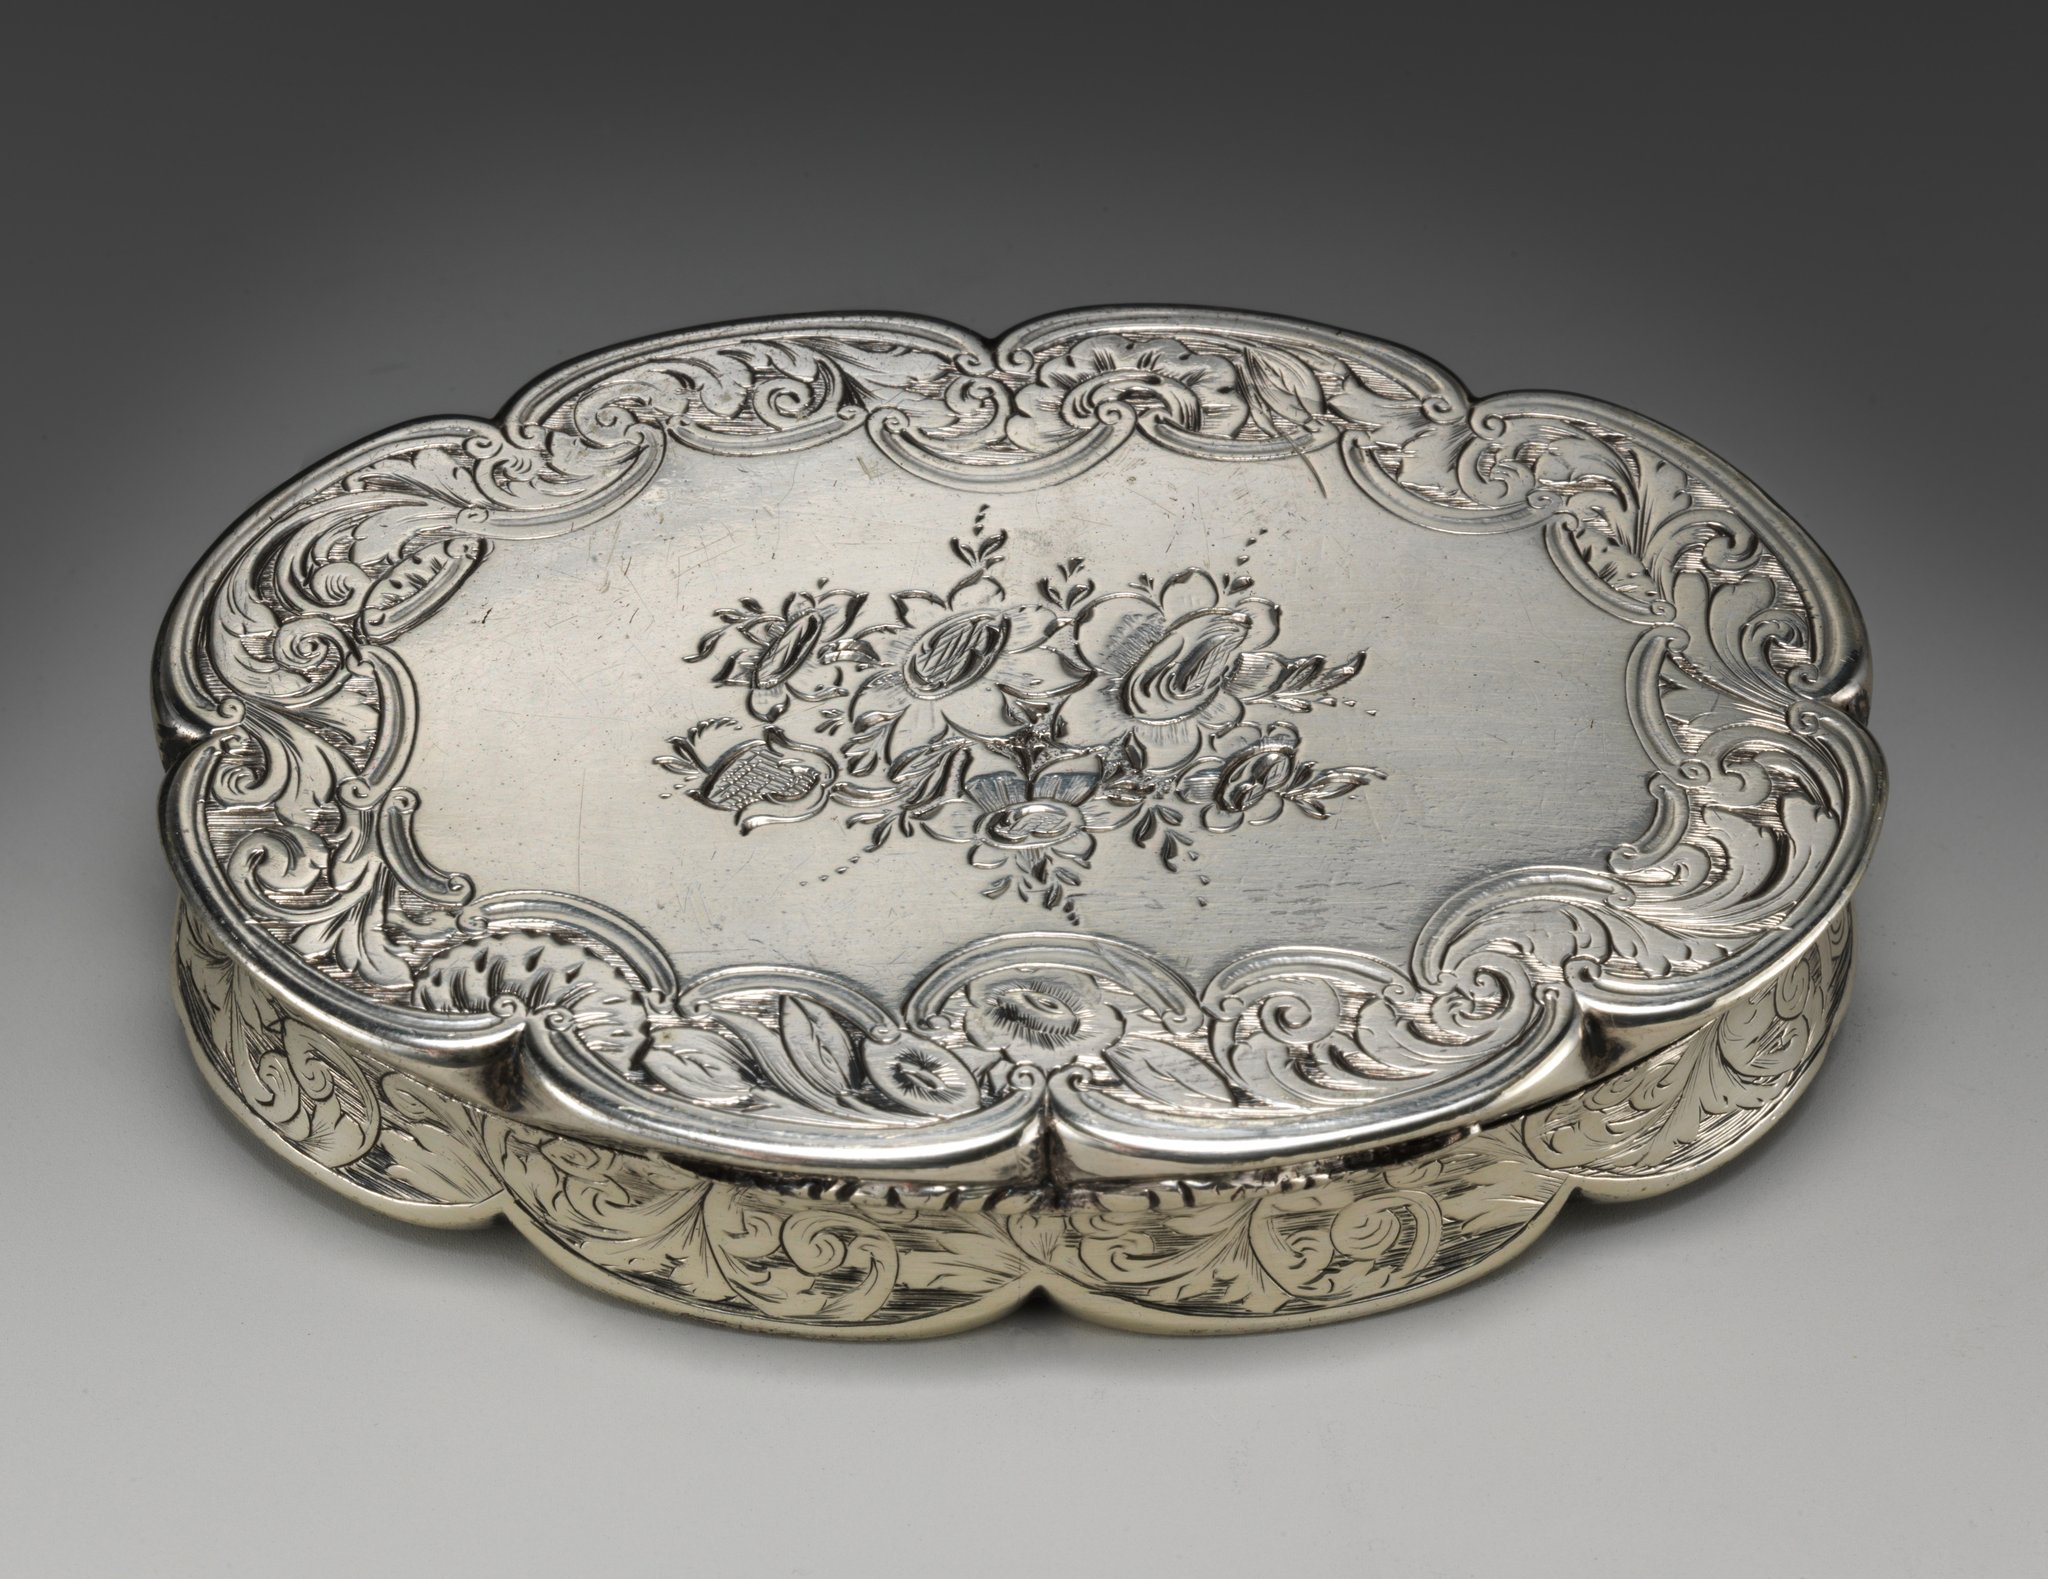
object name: box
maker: nathaniel mills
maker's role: maker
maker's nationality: british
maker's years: 1746-1843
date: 1843-1844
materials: silver